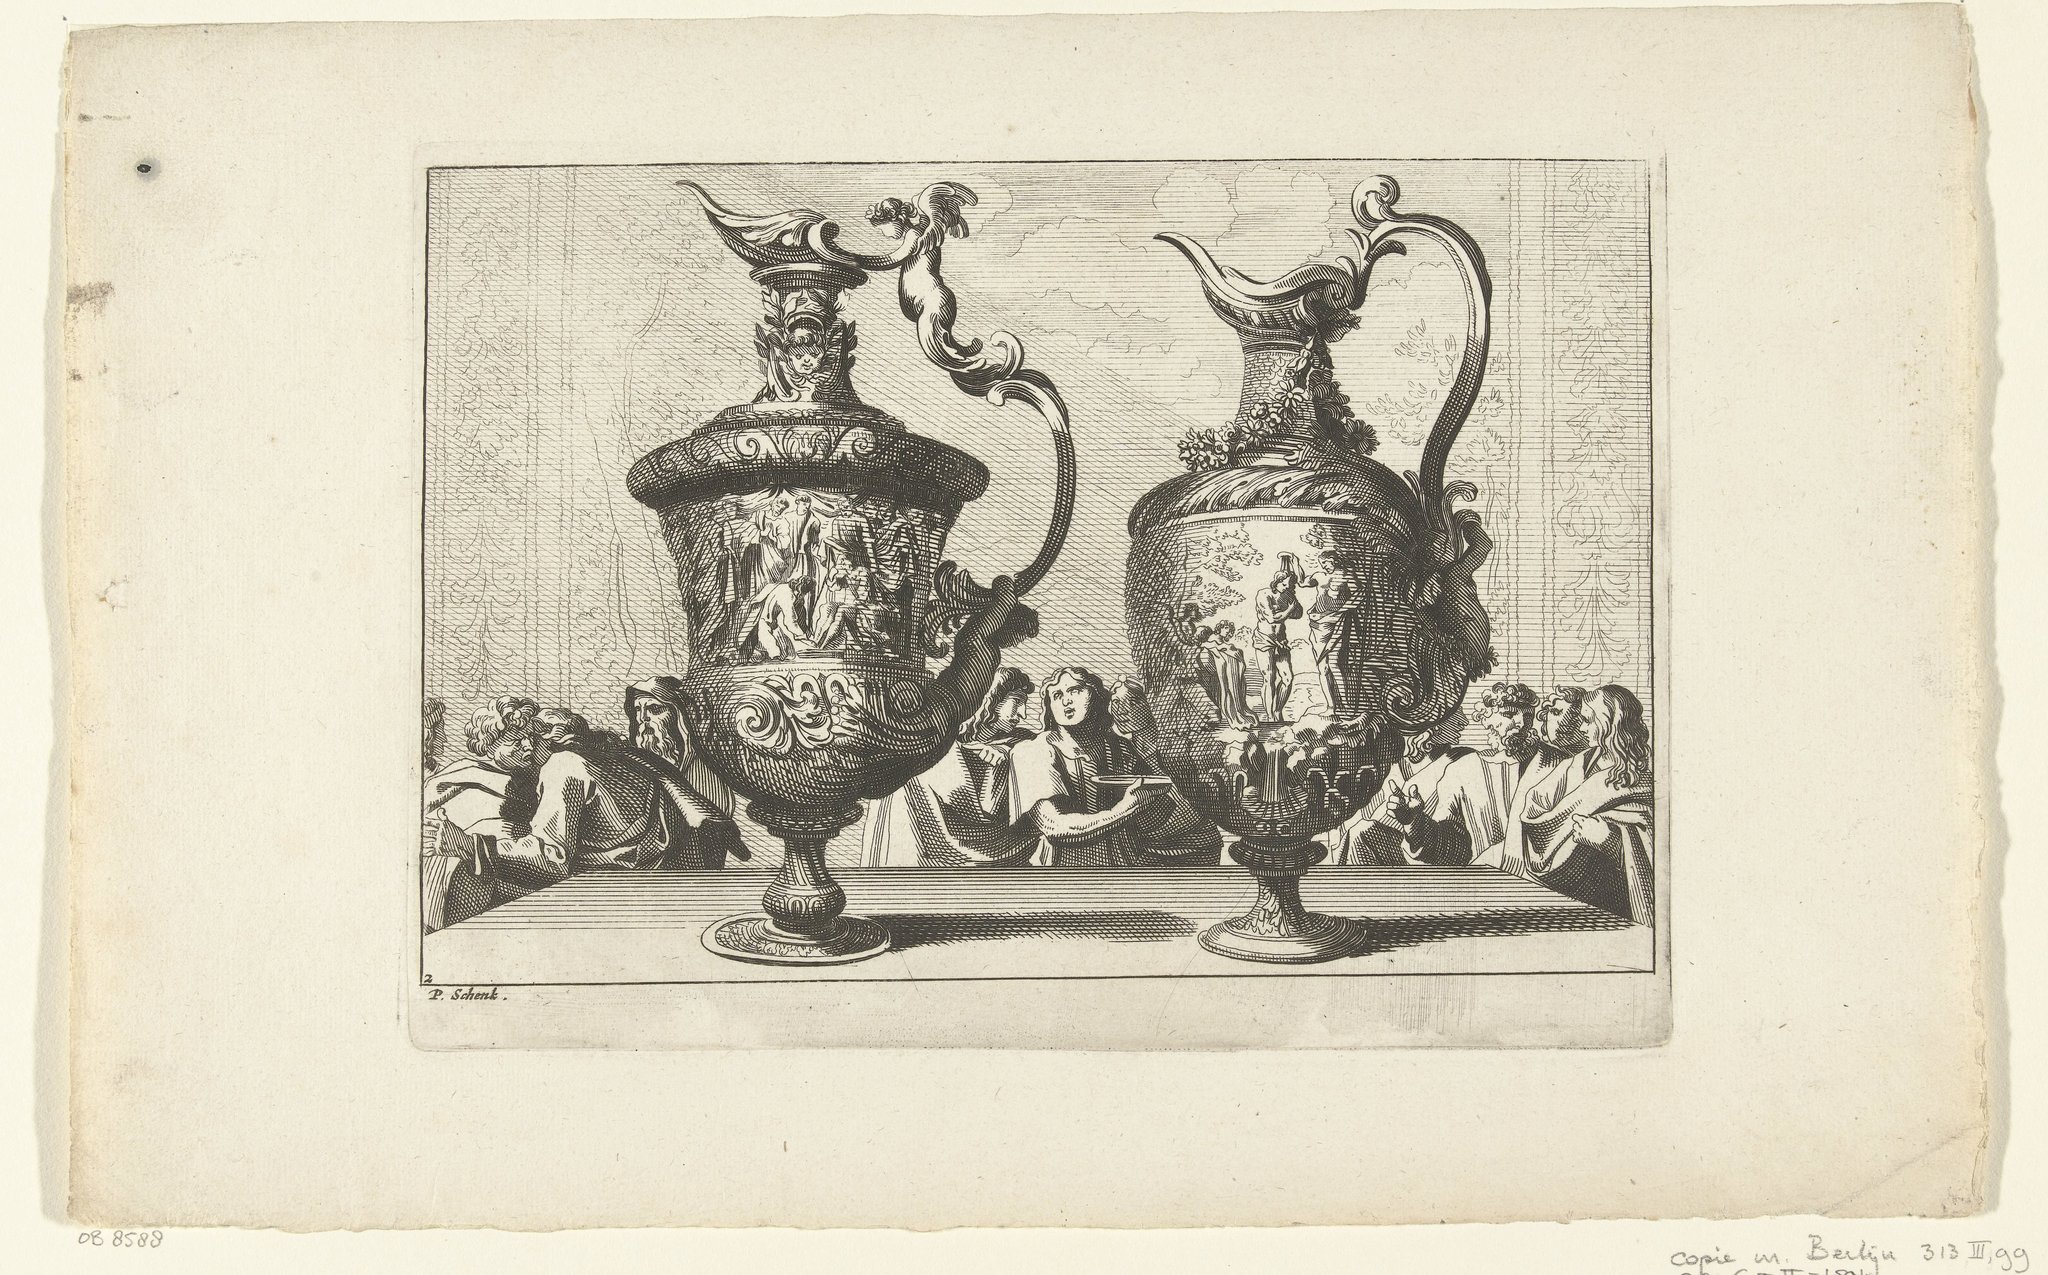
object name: print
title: Twee schenkkannen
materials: paper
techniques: etching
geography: netherlands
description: Op de schenkkan links staat de Voetwassing, op de schenkkan rechts de Doop van Christus. Nederlandse kopie naar blad 3 uit de serie Vases ou Burettes a la Romaine uitgegeven door Nicolas Langlois.